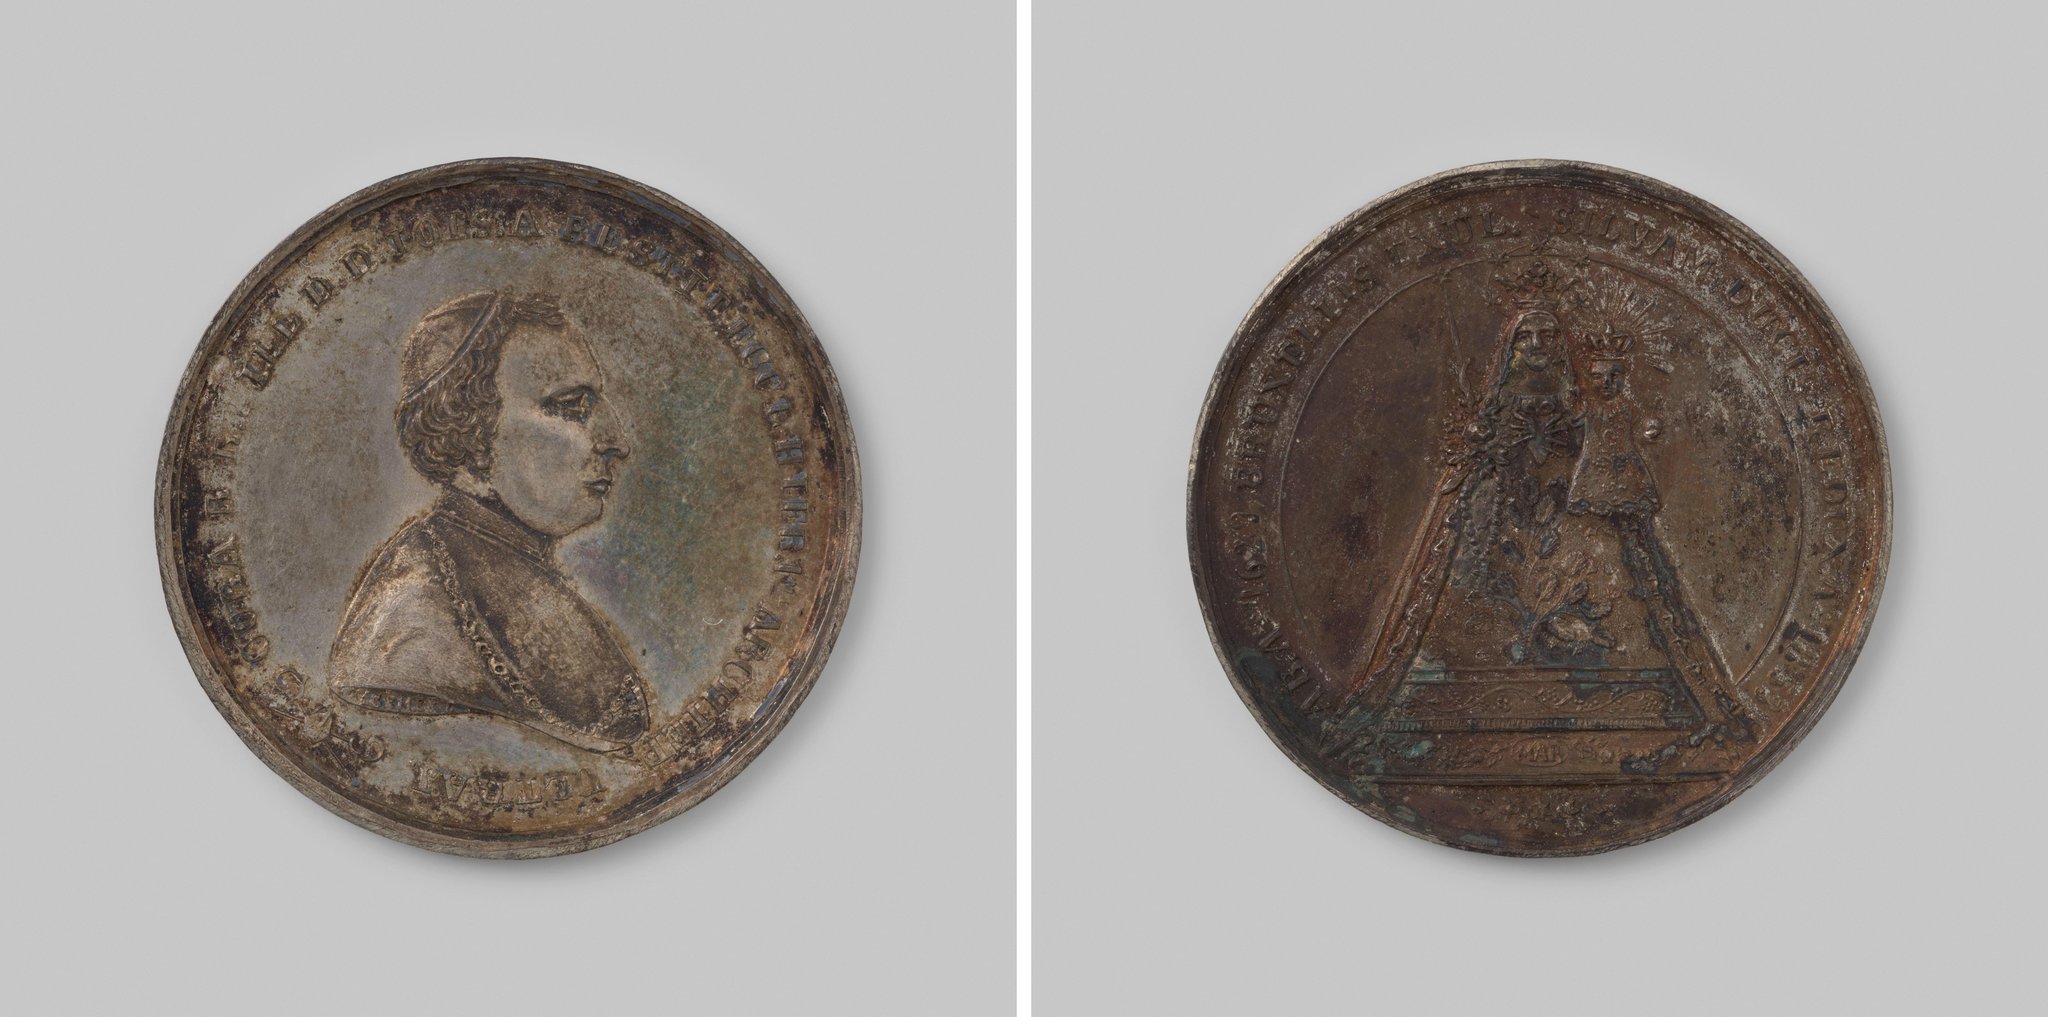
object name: history medal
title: Terugkeer uit Brussel van het Mariabeeld van 's-Hertogenbosch, ter ere van Johannes Zwijsen, aartsbisschop van Utrecht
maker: c. van gemert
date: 1853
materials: silver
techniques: striking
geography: netherlands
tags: utrecht, den bosch, brussels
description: Zilveren penning. Voorzijde: borststuk man binnen omschrift. Keerzijde: beeld van Maria met kind binnen omschrift